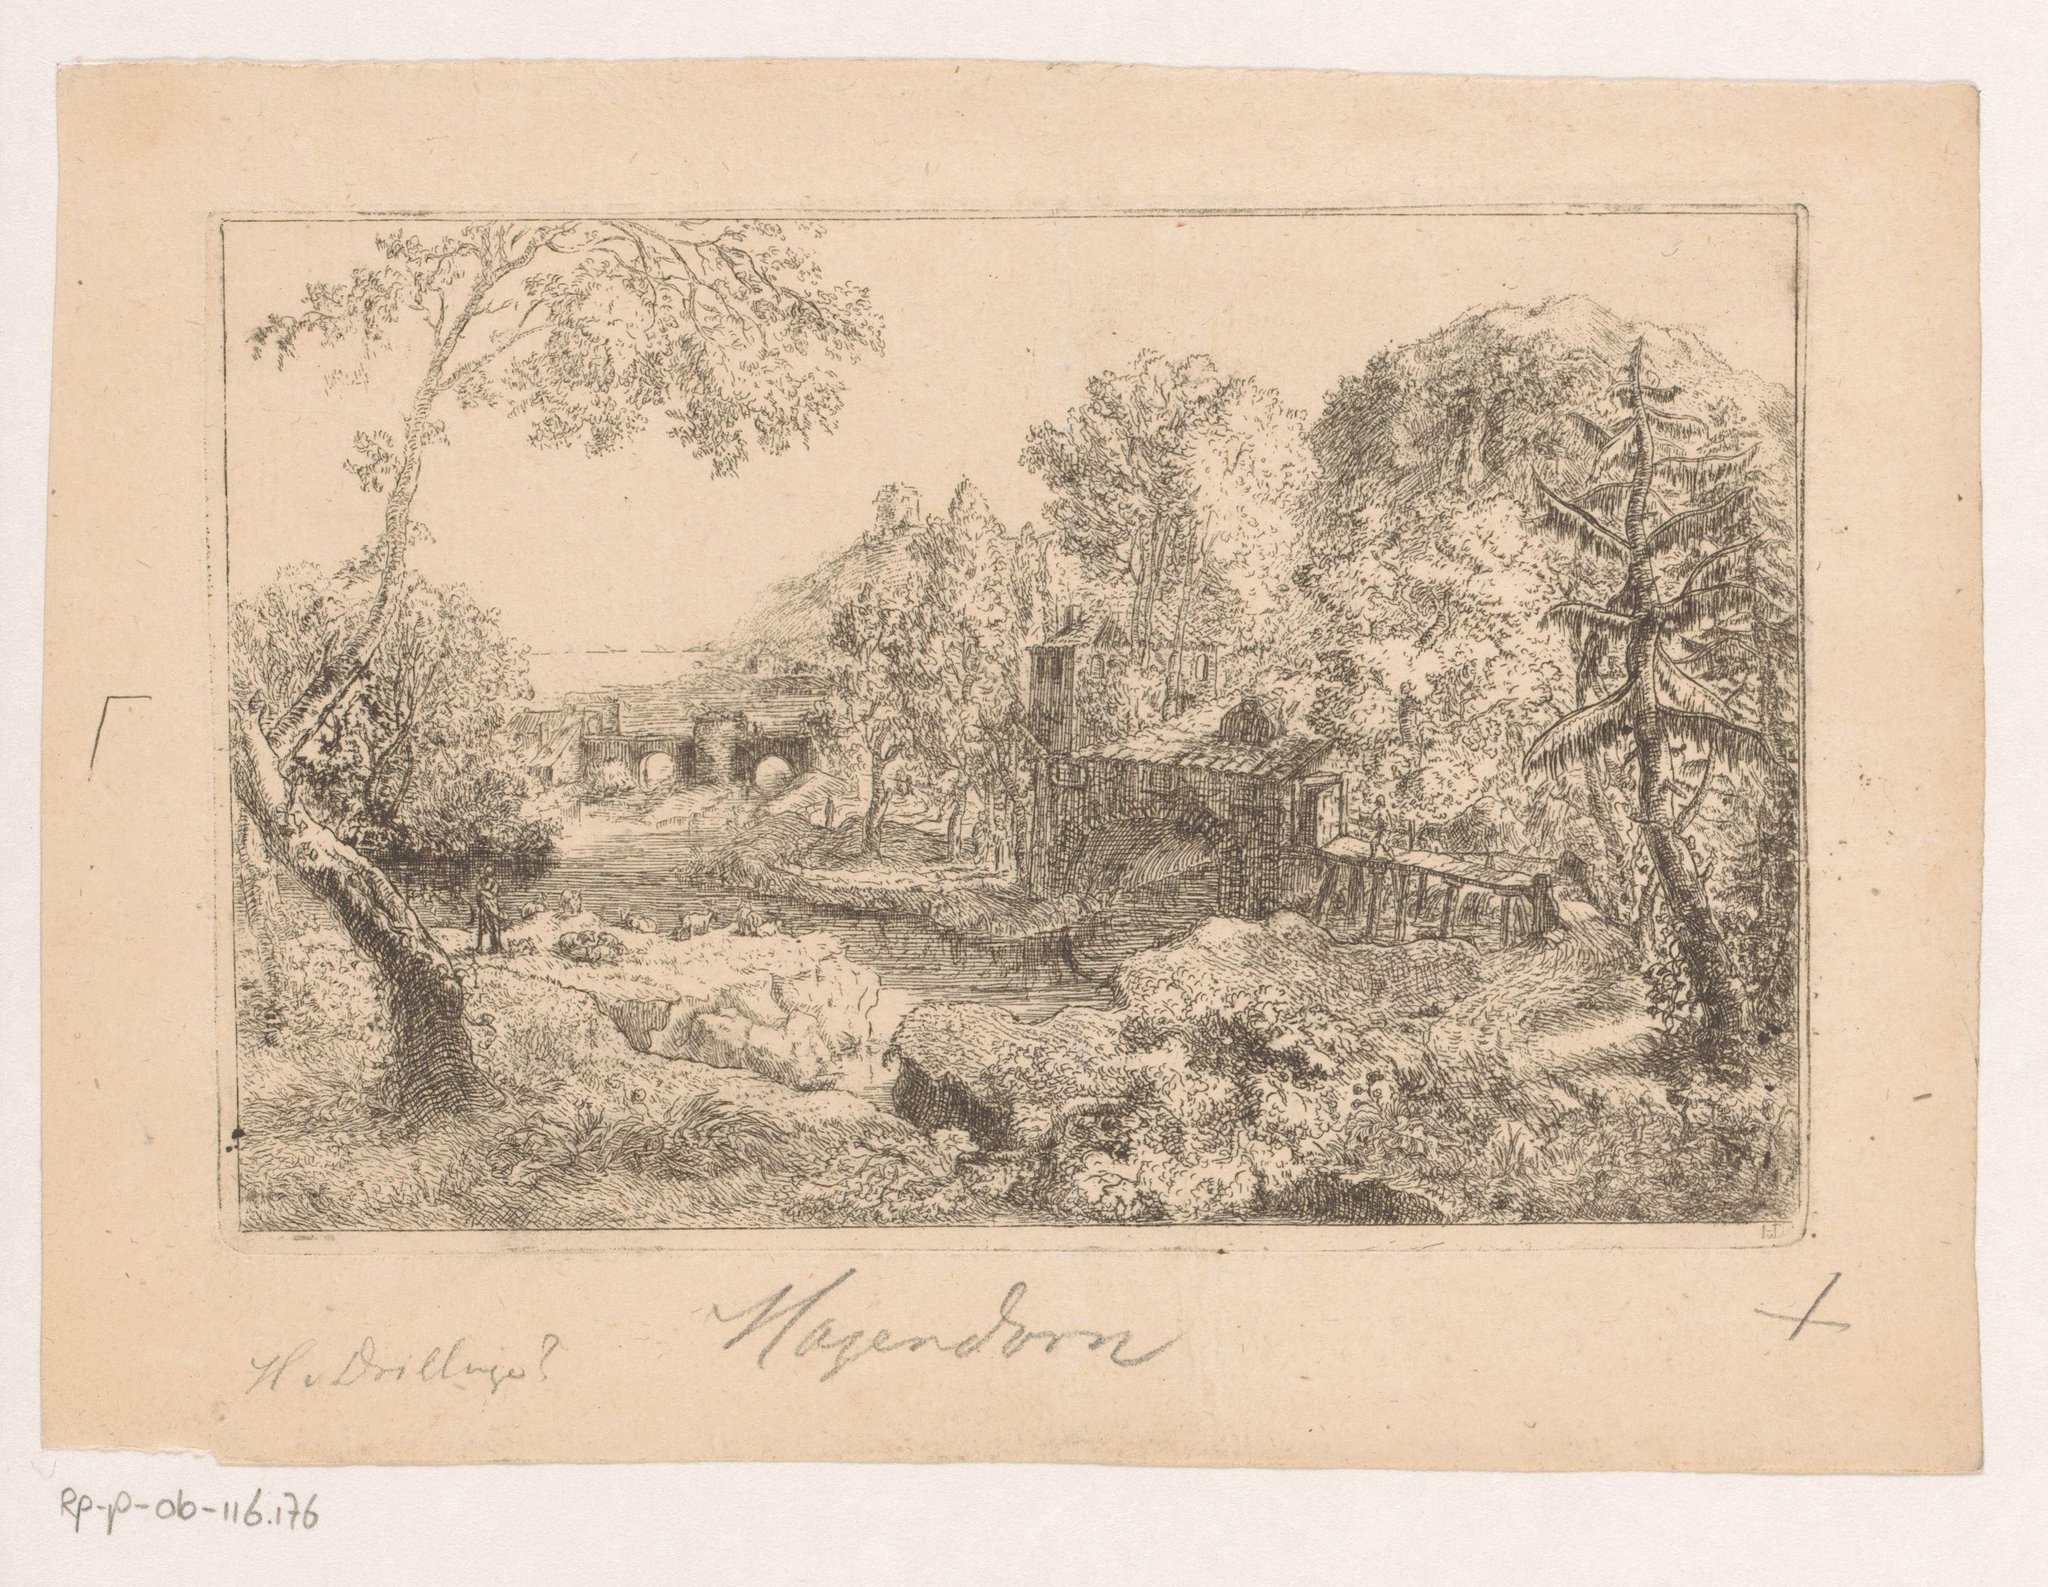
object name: print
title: Landschap met een gemaal tussen bomen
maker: christian ludwig von hagedorn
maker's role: painter, print maker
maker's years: 1712-1780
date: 1722-1780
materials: paper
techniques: etching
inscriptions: collector's mark: Lugt 2228